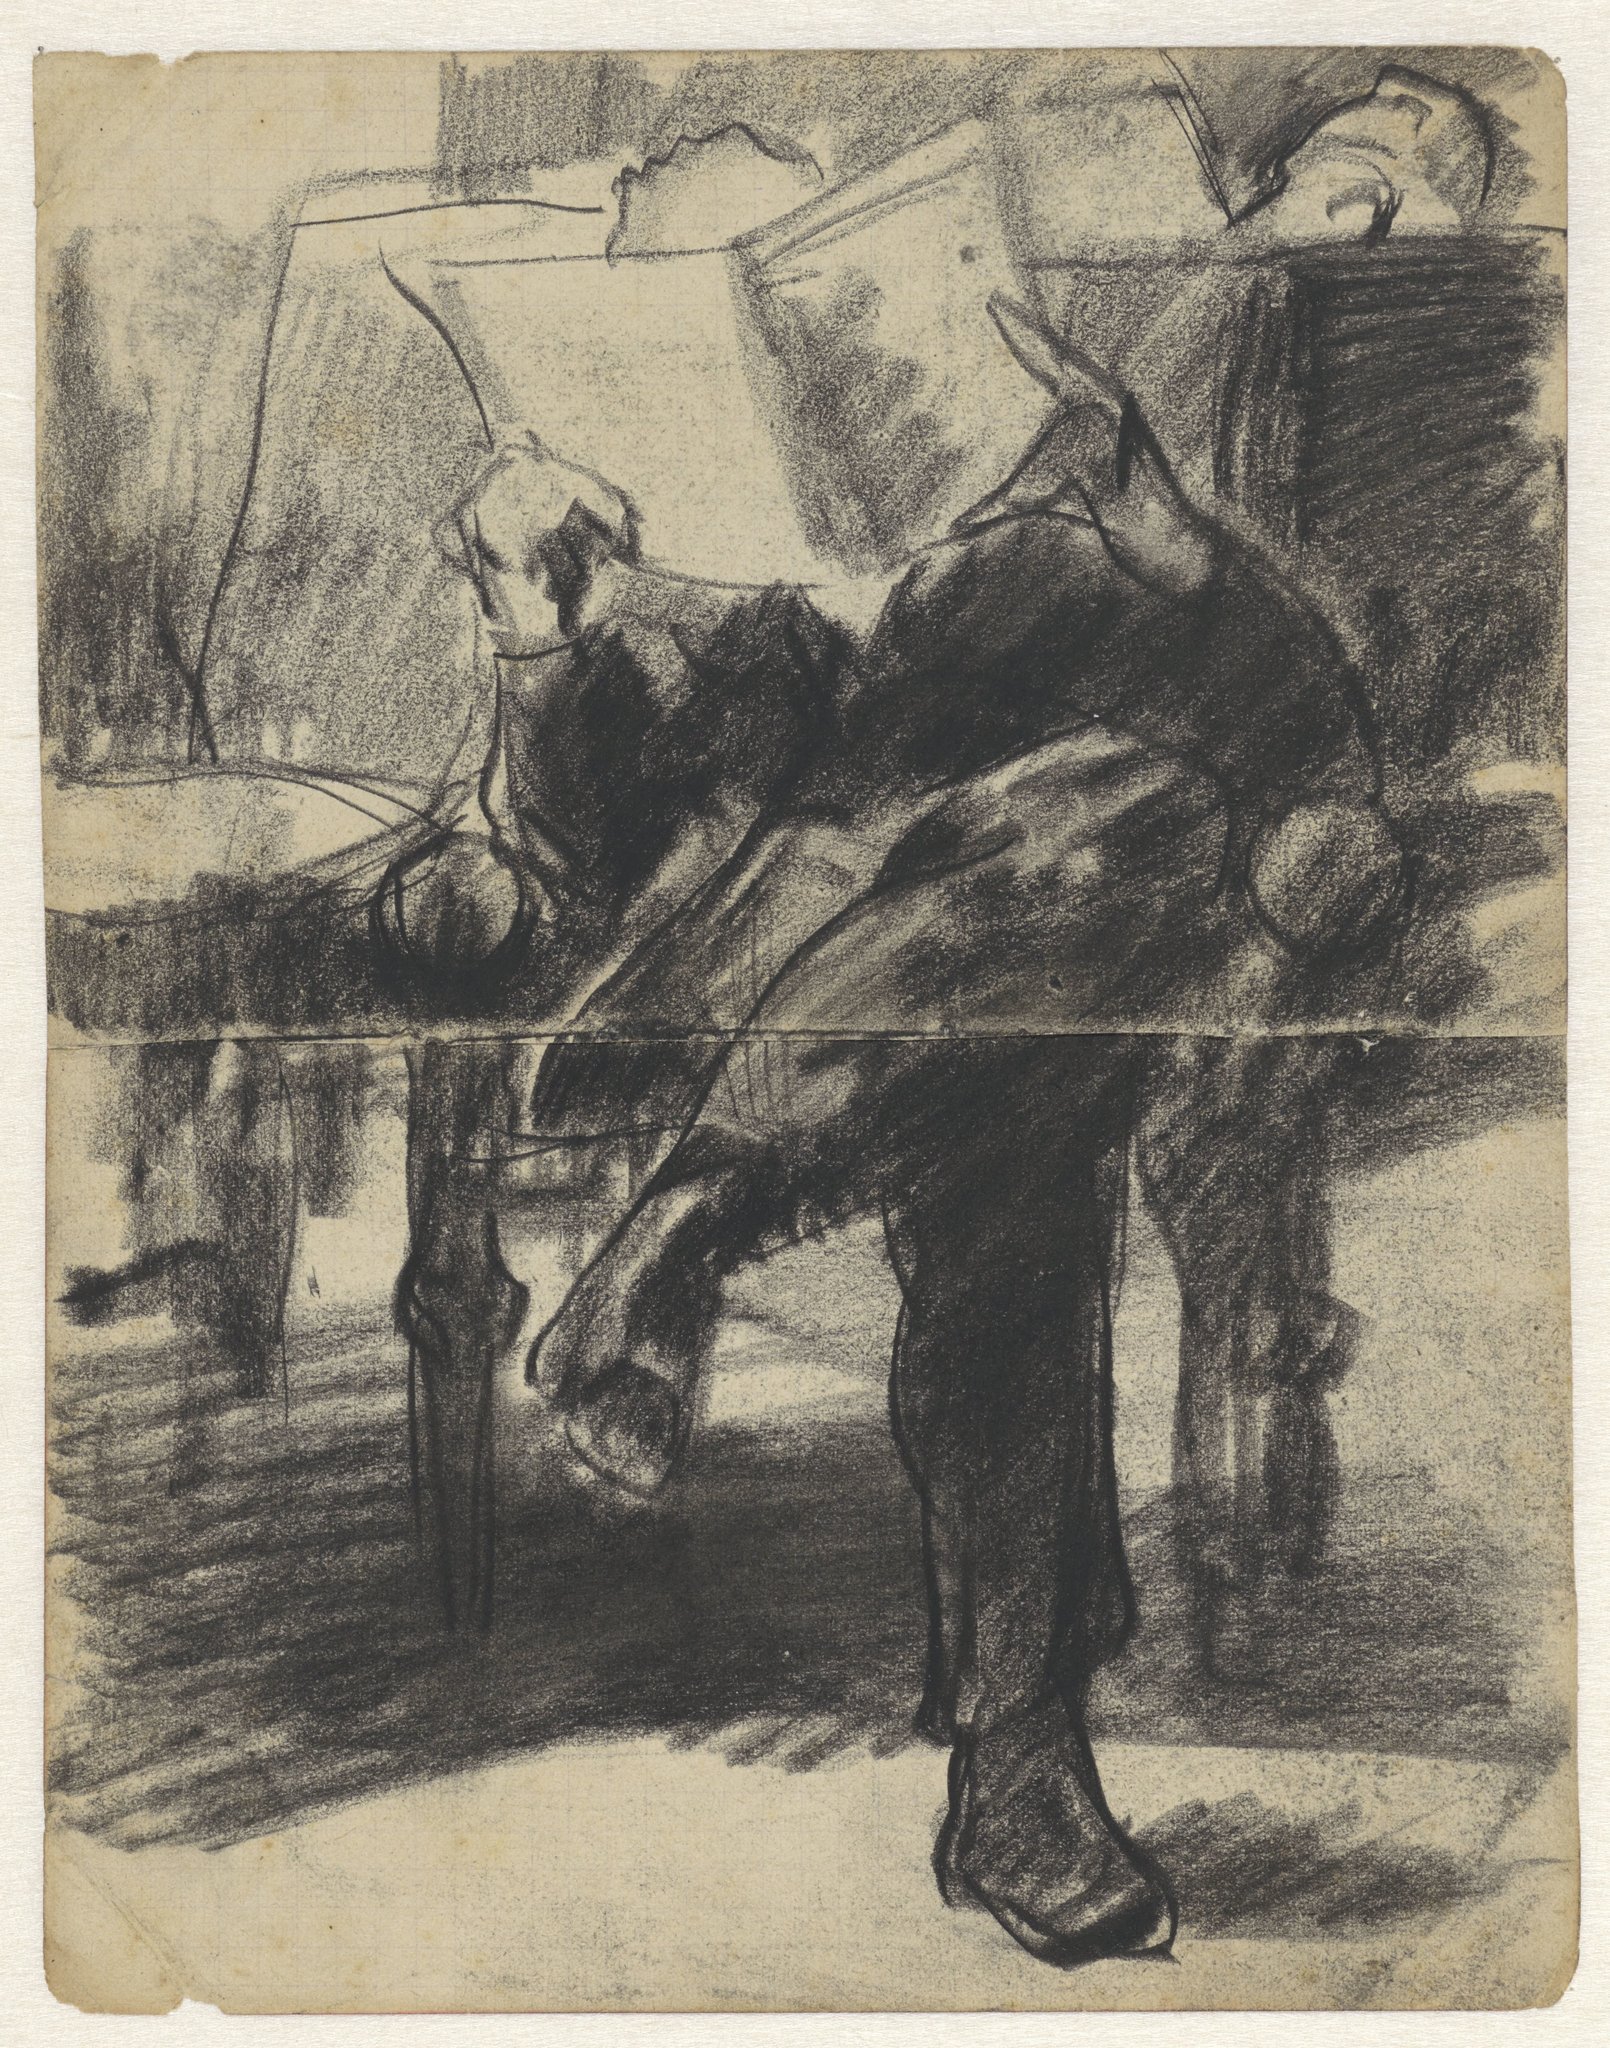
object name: drawing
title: Krantenlezer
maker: jac van looij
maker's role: draughtsman, painter, print maker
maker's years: 1855-1930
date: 1865-1930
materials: chalk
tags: reading